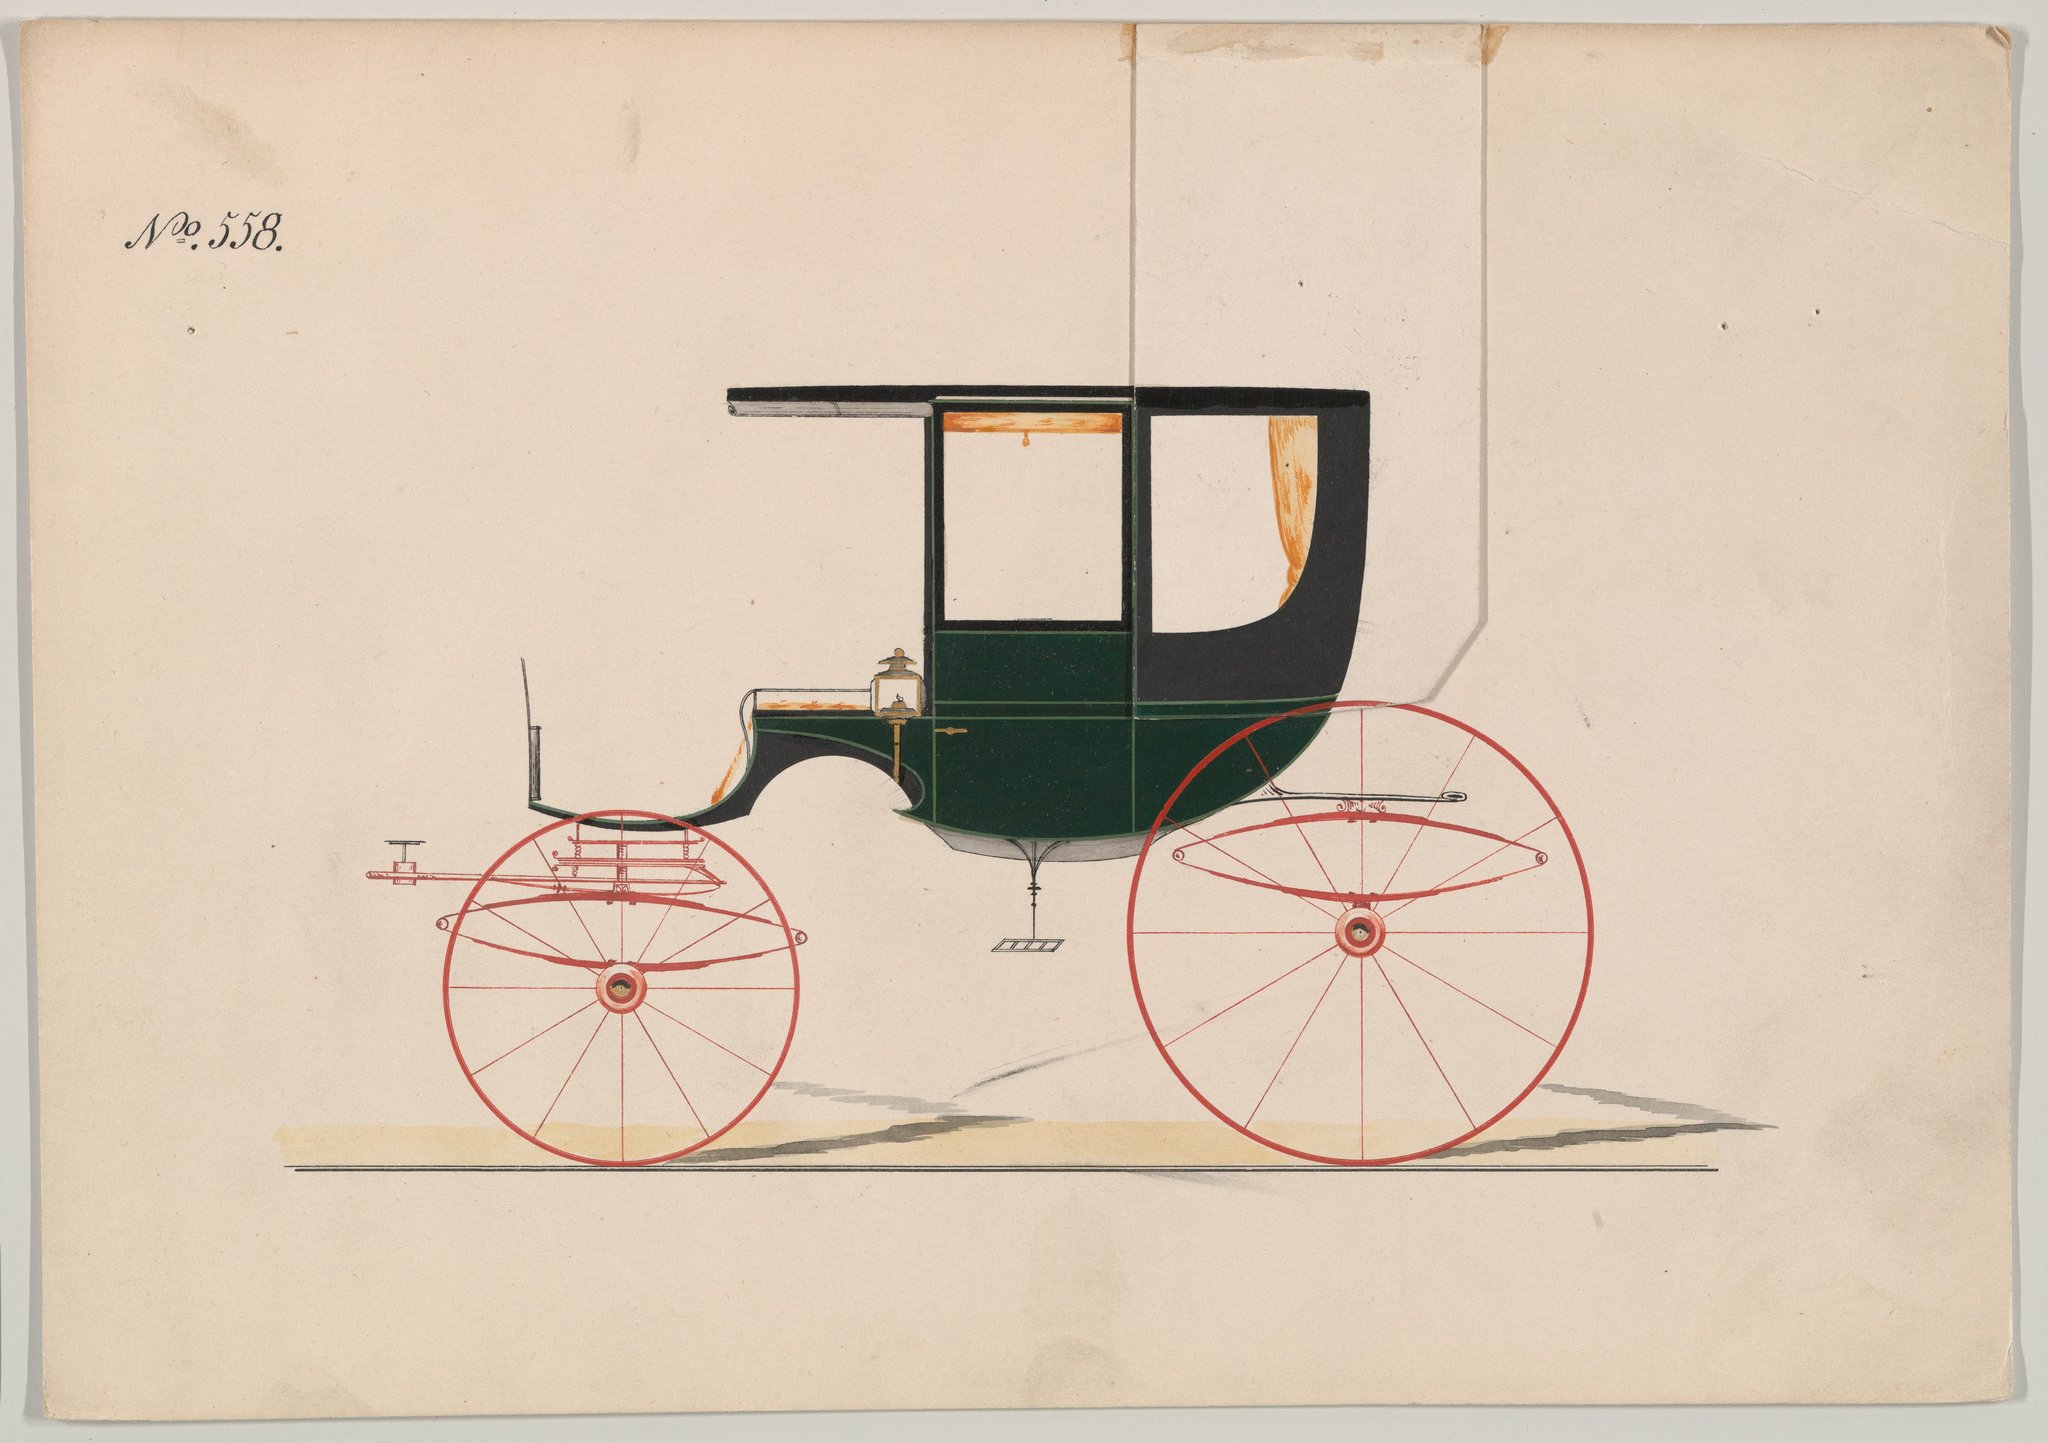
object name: drawing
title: Rockaway #558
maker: brewster & co.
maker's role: manufacturer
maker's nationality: american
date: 1865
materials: gouache, gum arabic, ink, watercolor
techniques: pen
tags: carriages